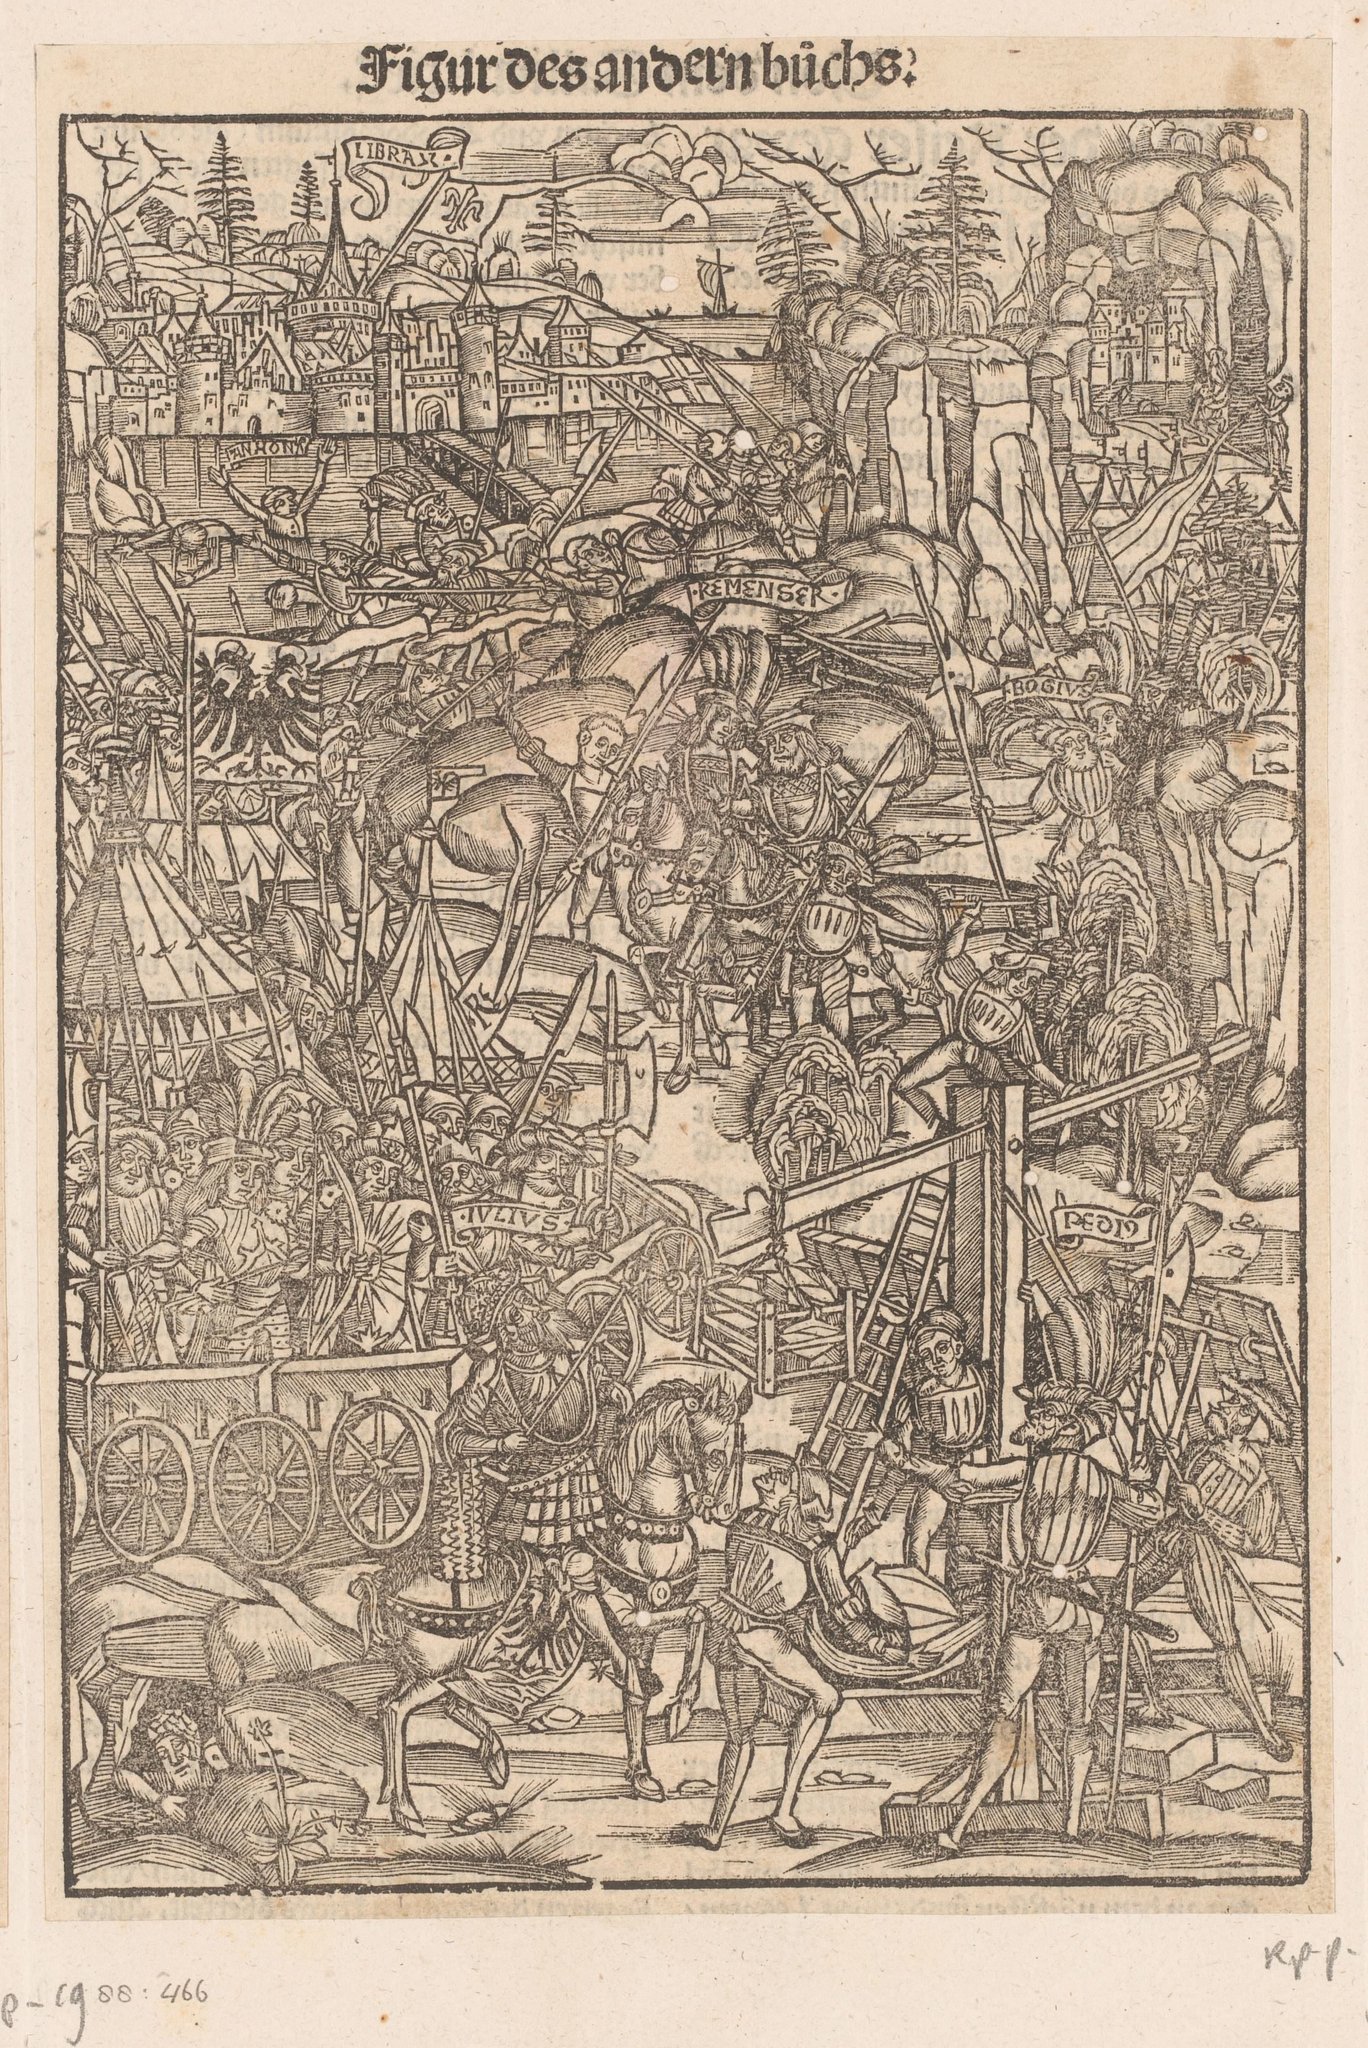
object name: book illustration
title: Veldslag van Julius Caesar tegen de Galliërs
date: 1508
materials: paper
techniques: woodcut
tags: aggressive relationships of c. julius caesar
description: Prent voor het eerst gebruikt in: Ringmann, Matthias. Julius der erste Römisch Keiser von seinem leben vnd Kriegen. Straatsburg: Johann Grüninger, 1508.